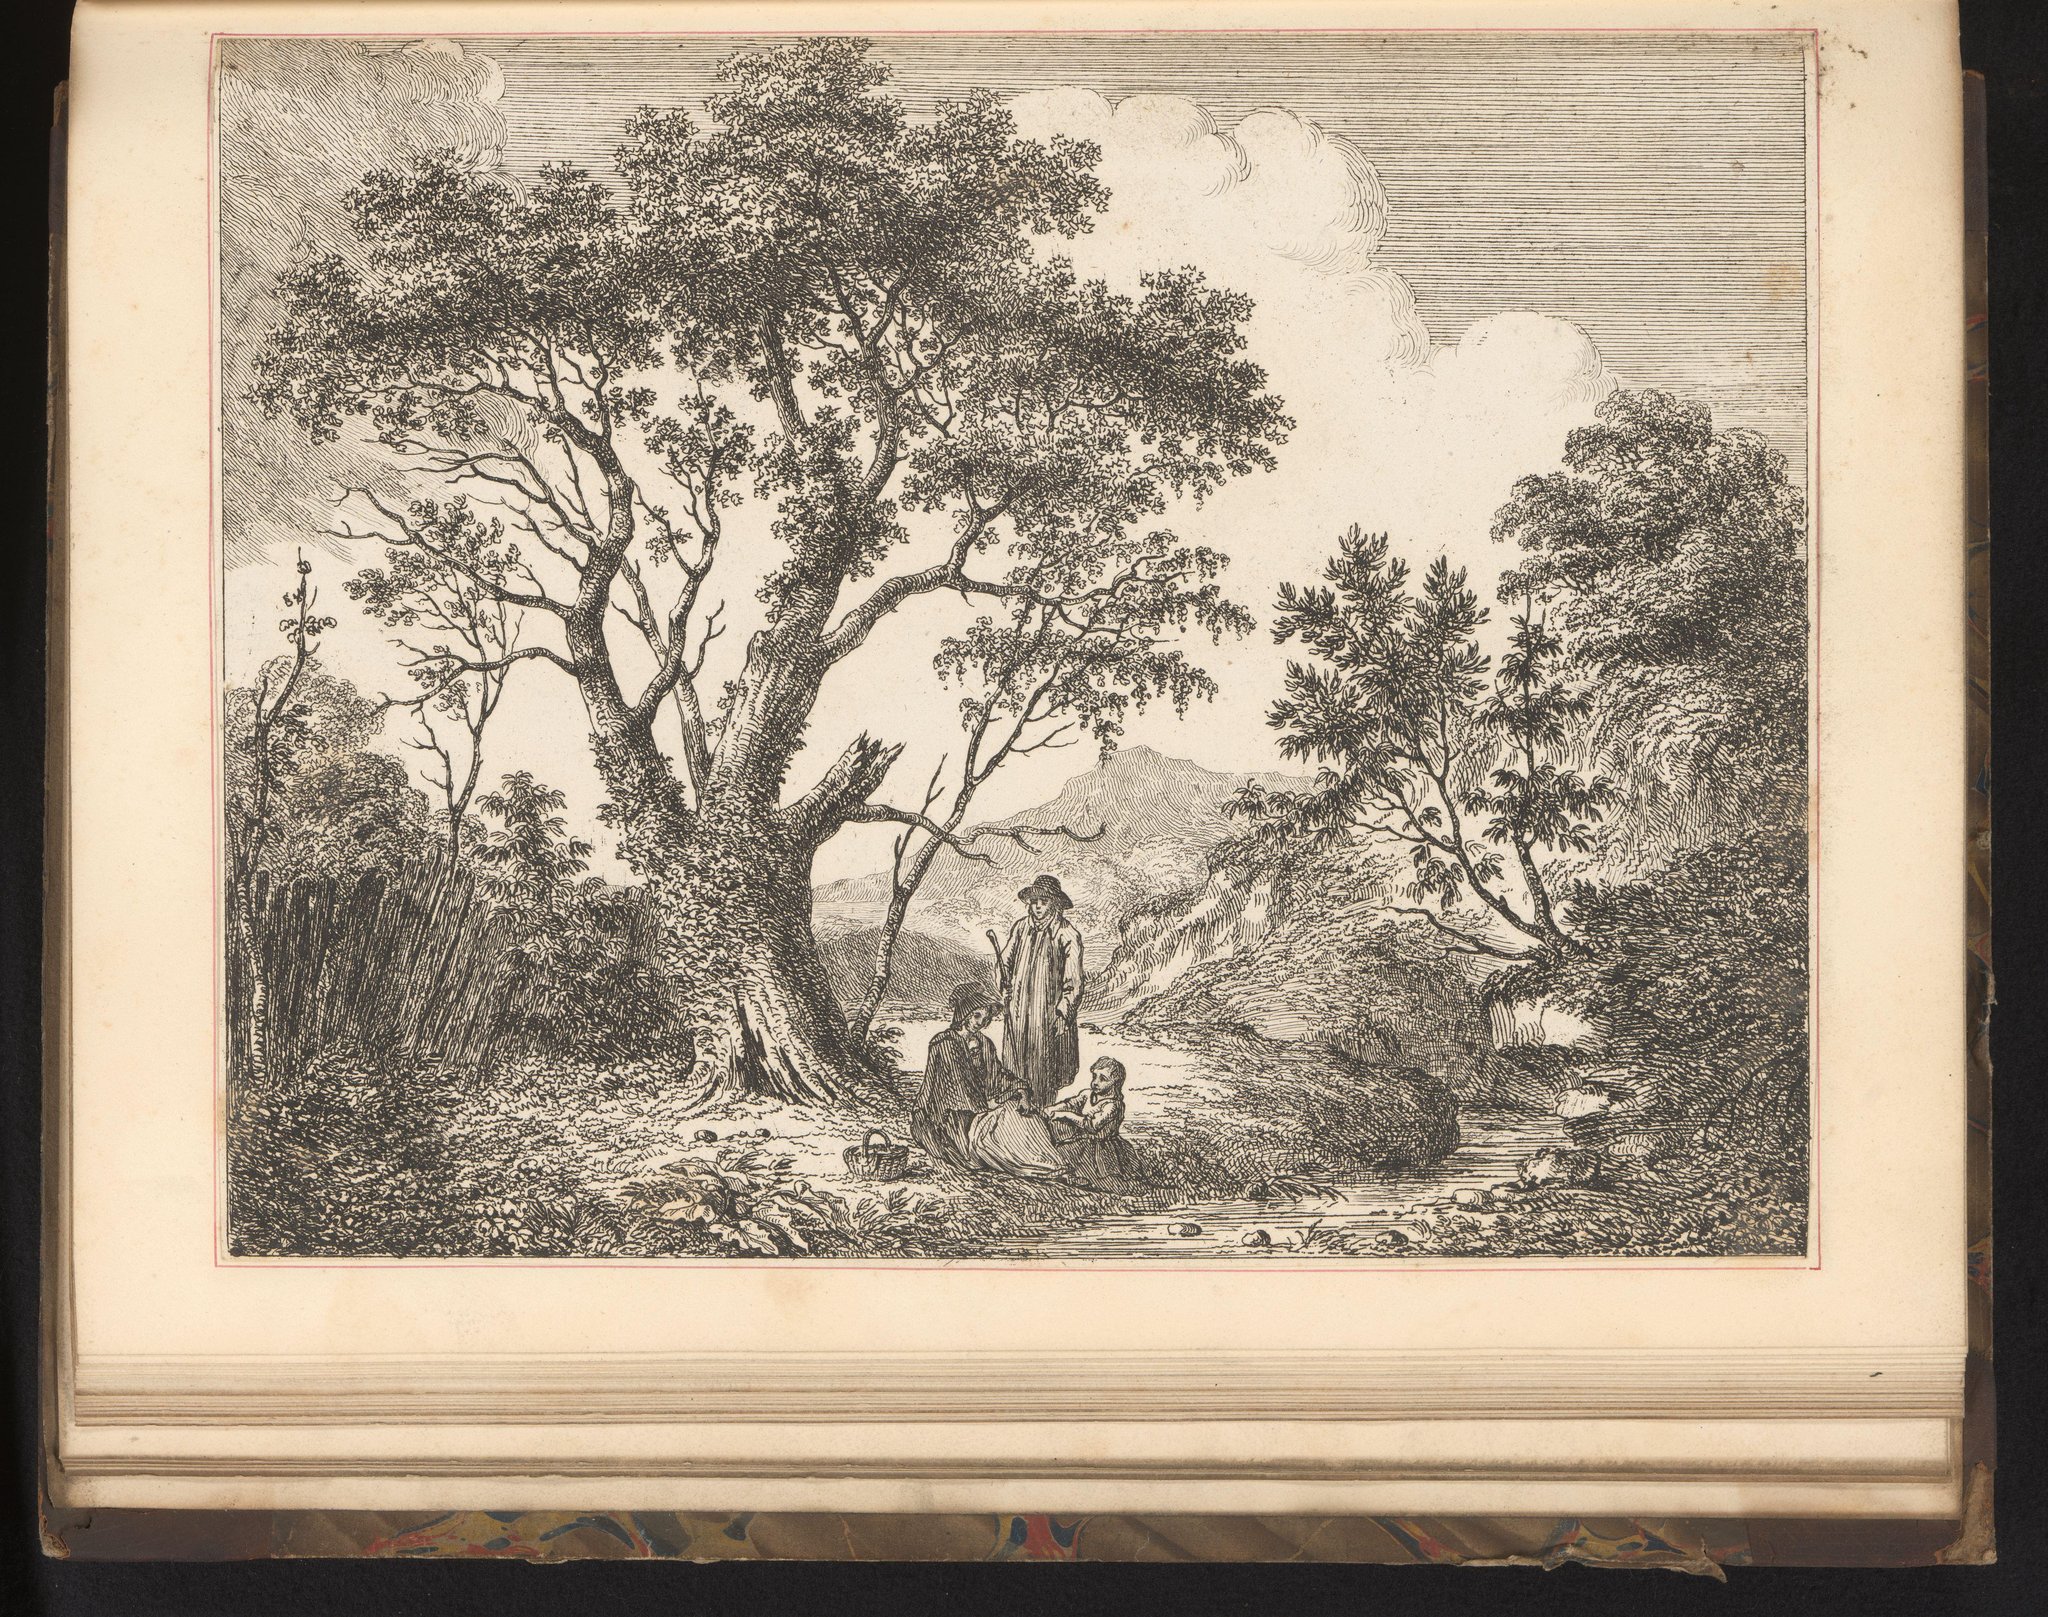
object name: print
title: Etchings by E. Edwards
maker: edward edwards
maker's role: painter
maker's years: 1738-1806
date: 1748-1806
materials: paper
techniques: etching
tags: parents with their children, landscapes (+ landscape with figures, staffage)